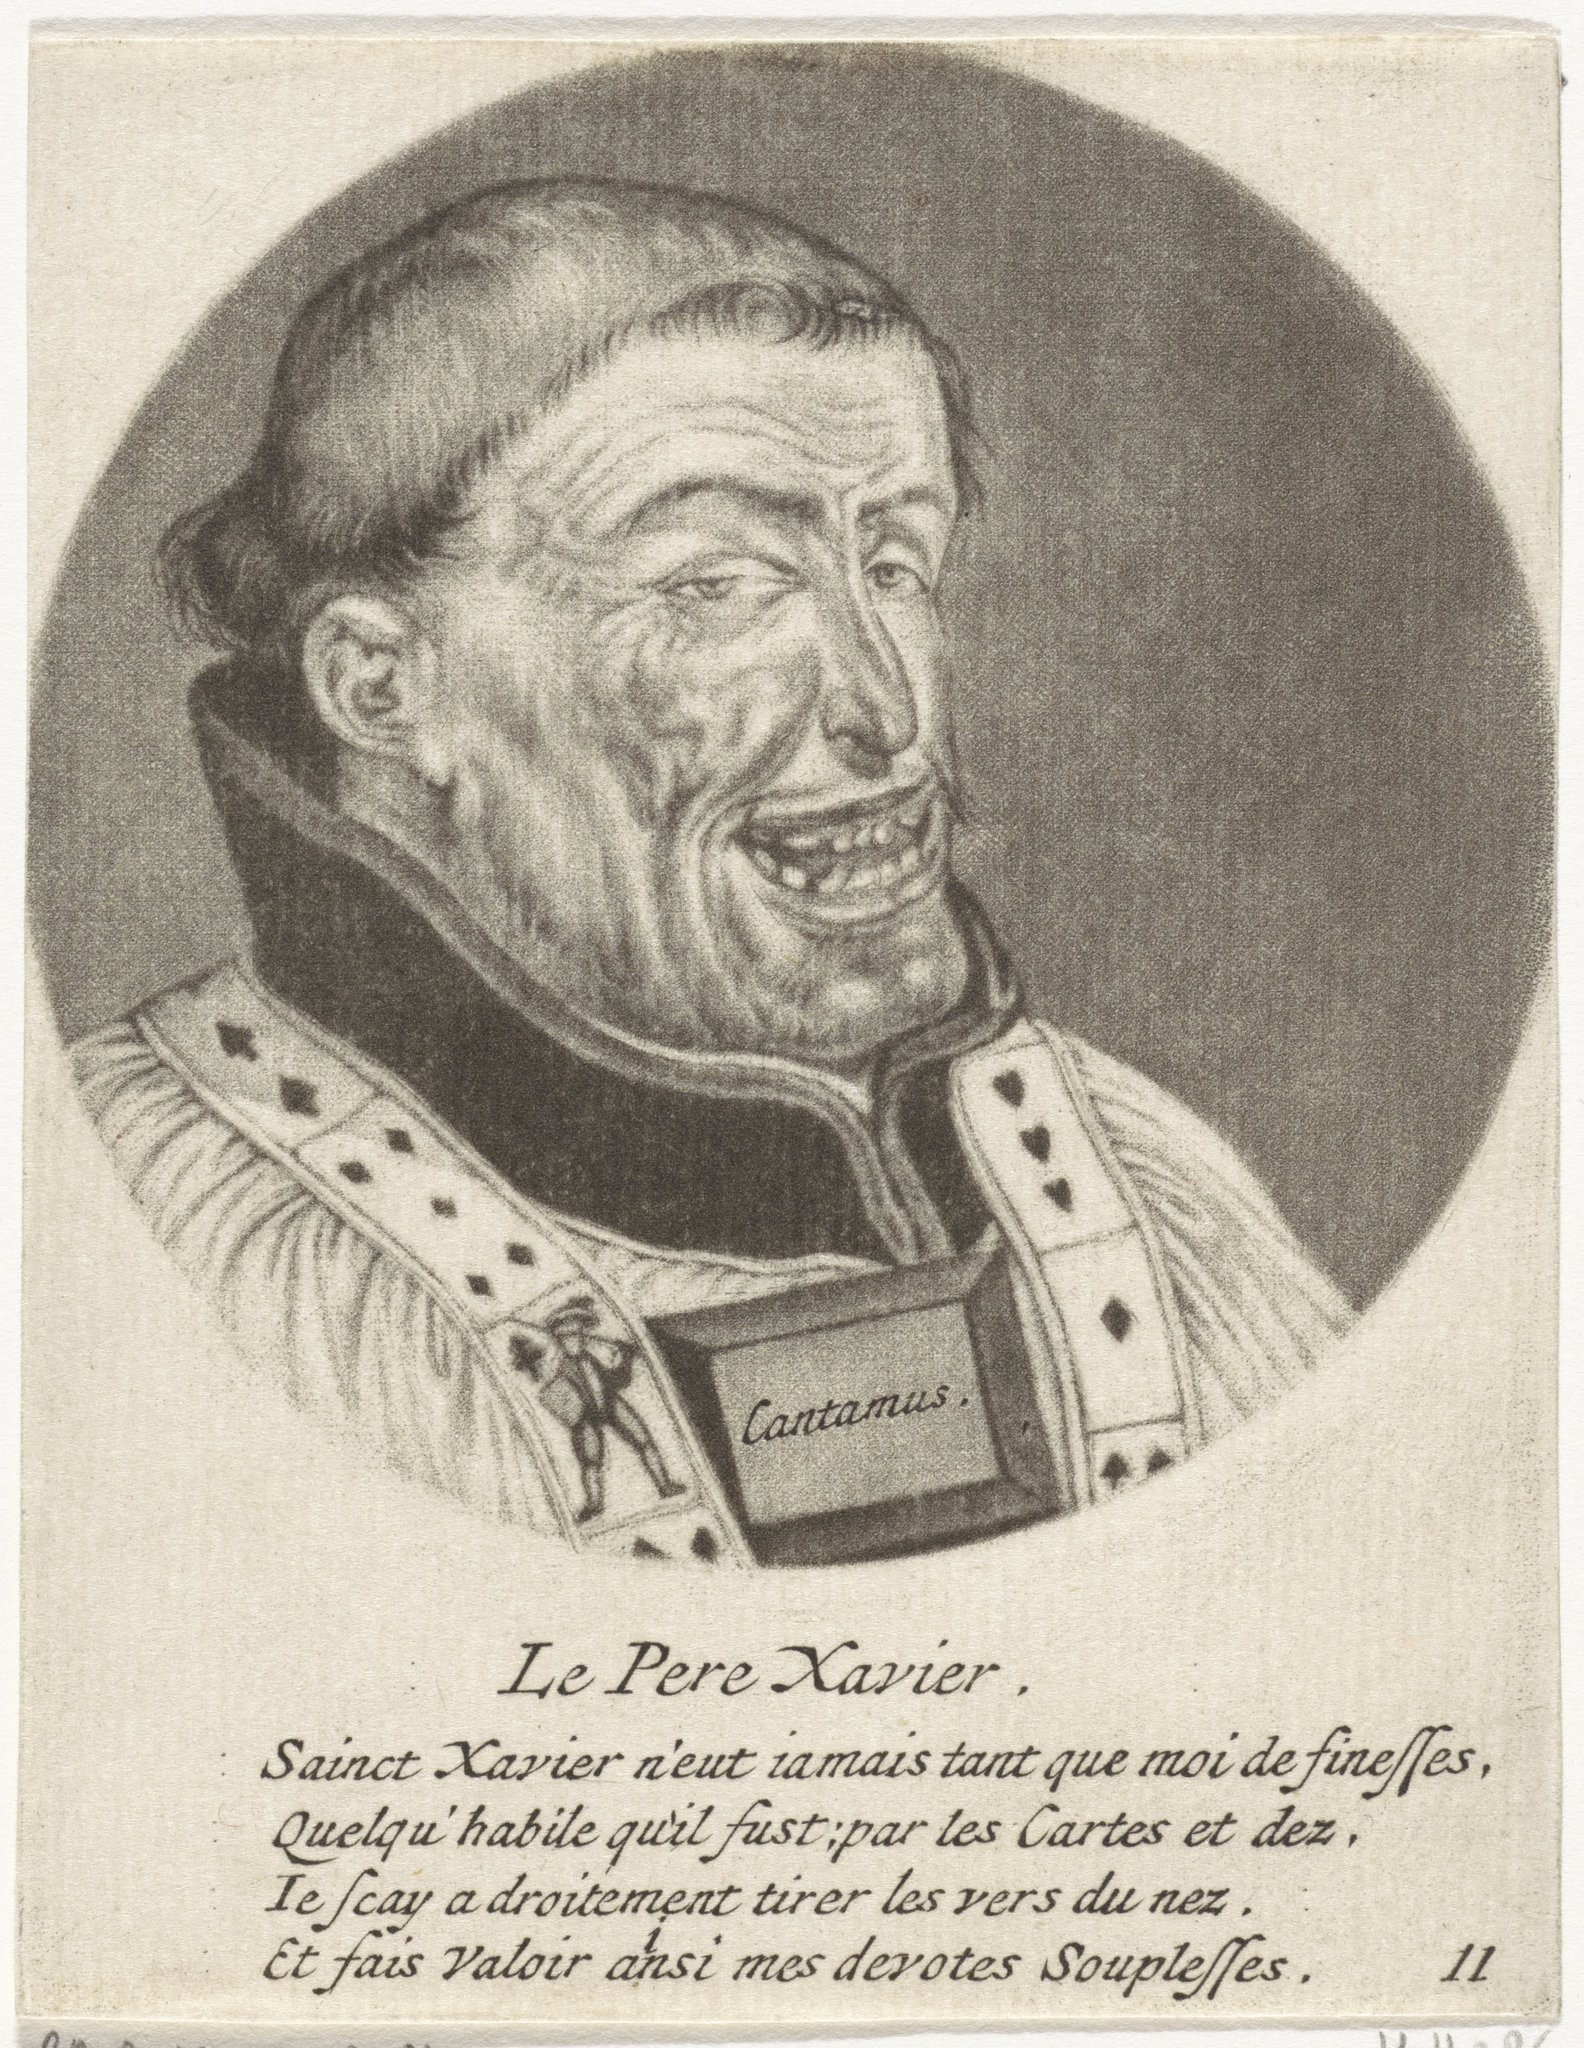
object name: print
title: Lachende monnik met speelkaarten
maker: jacob gole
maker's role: print maker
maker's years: 1660-1724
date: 1670-1724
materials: paper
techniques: engraving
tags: laughing, monk(s), friar(s), playing-cards, political caricatures and satires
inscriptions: collector's mark: Lugt 2228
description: Een lachende monnik met om zijn hals een lint van speelkaarten. Op zijn borst een bordje waarop de tekst "Cantamus". De prent maakt deel uit van een serie met karikaturen van de Franse geestelijkheid onder Lodewijk XIV.